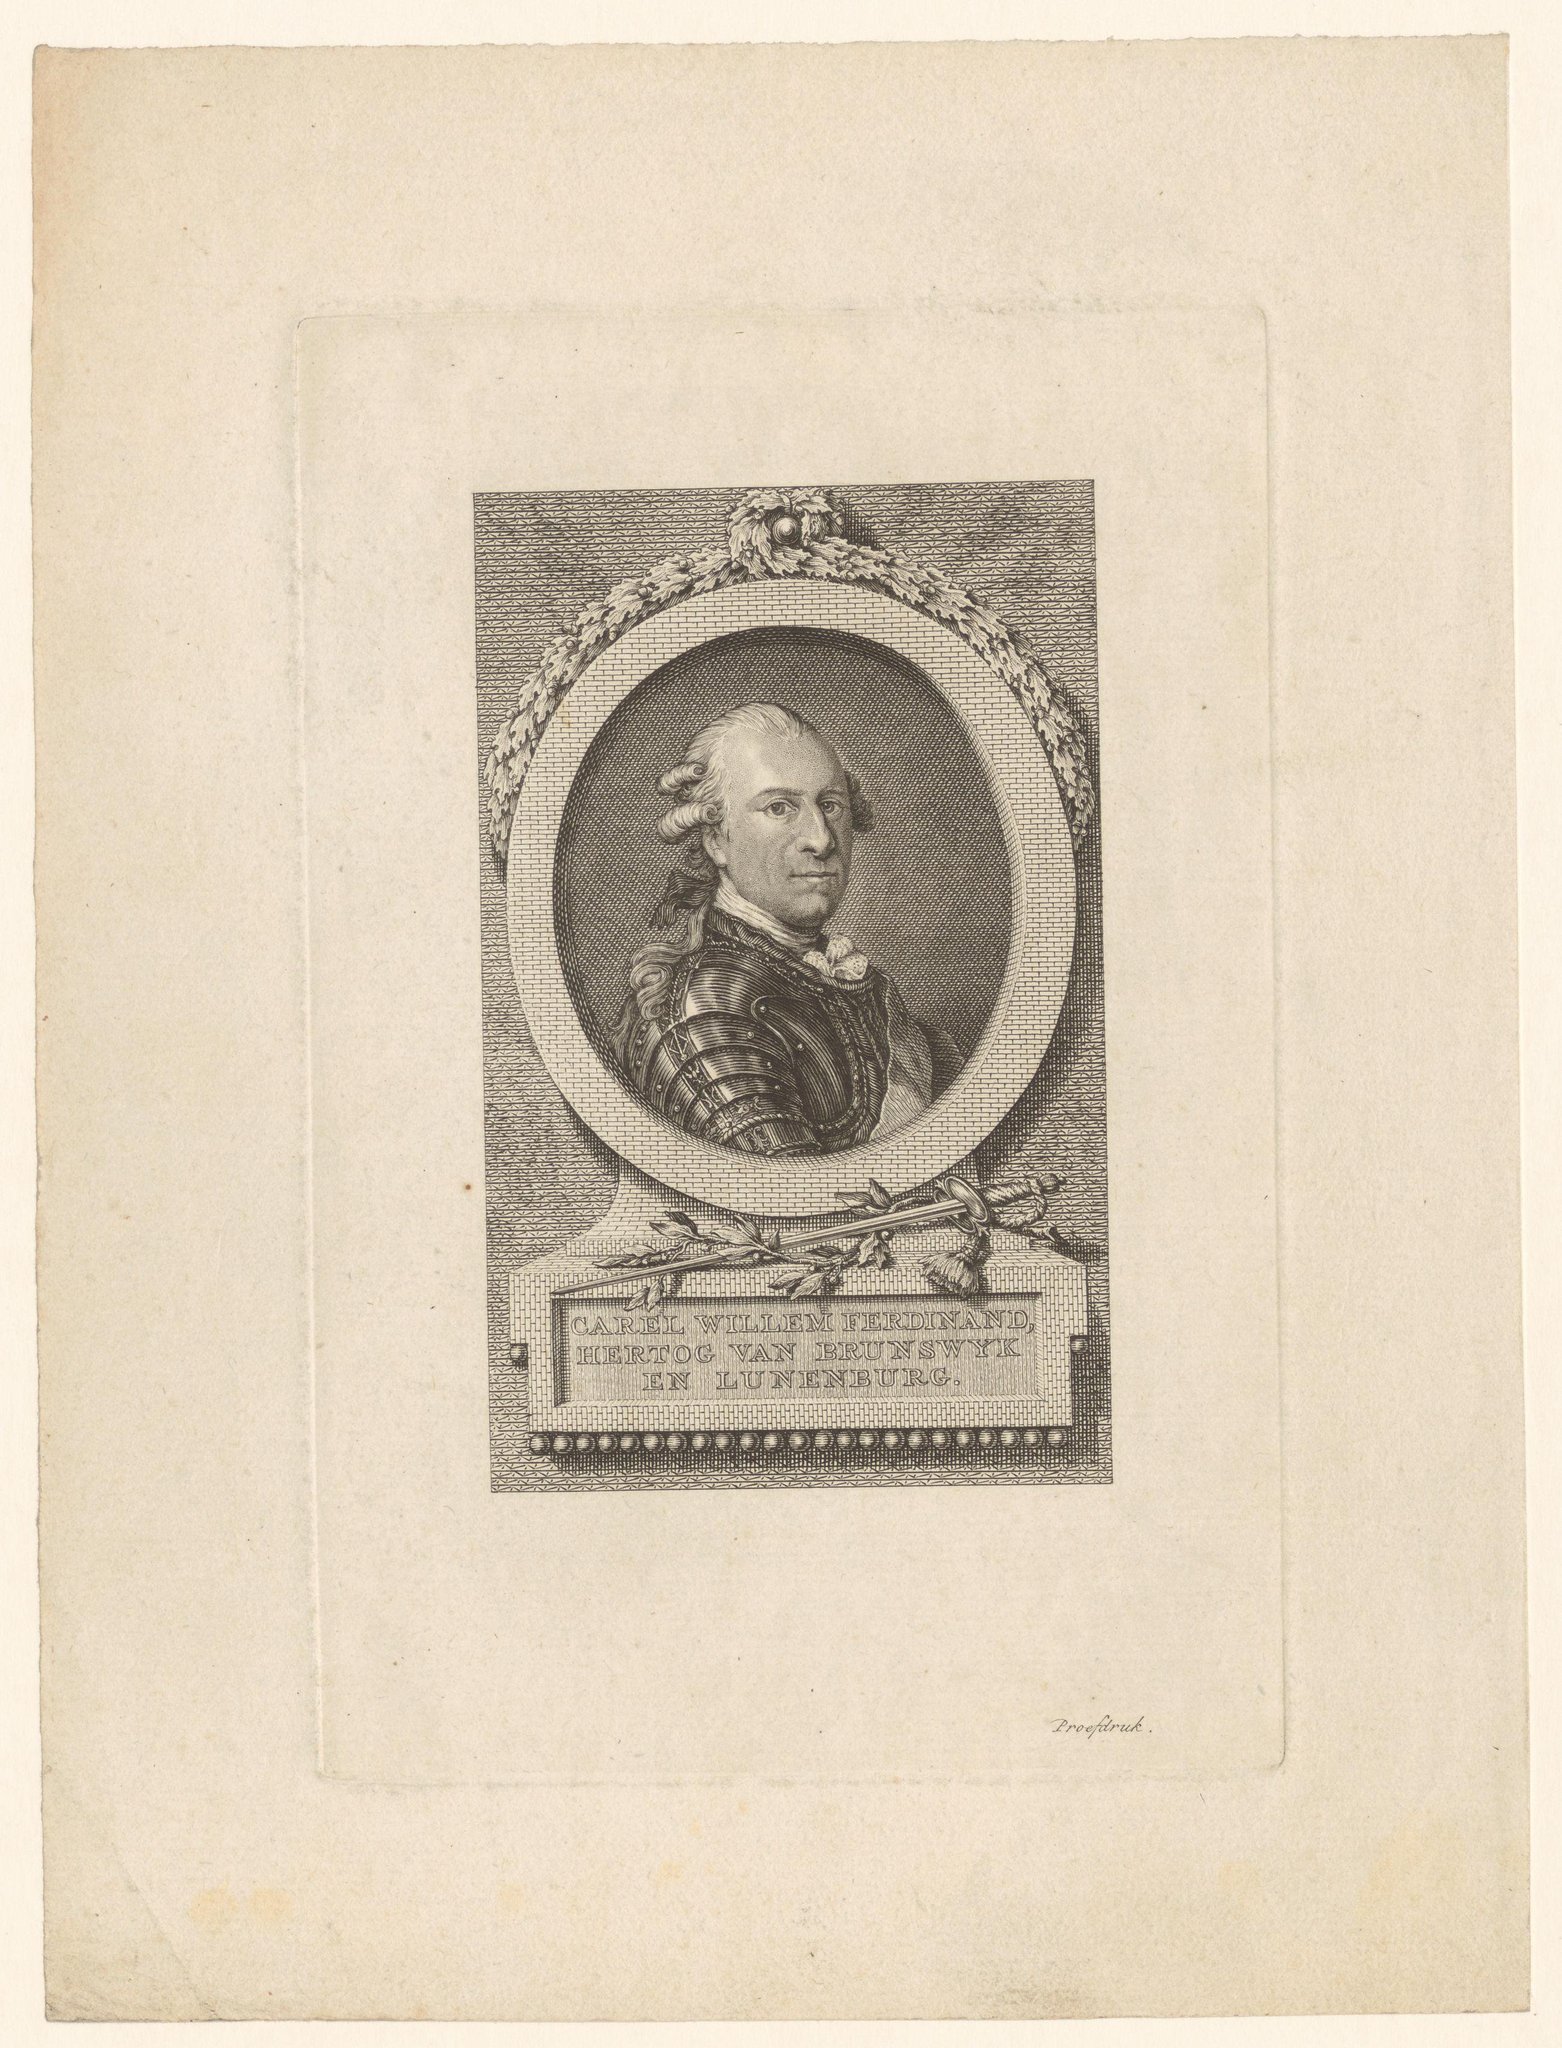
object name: print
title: Portret van Karl Wilhelm Ferdinand von Braunschweig-Wolfenbüttel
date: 1764-1807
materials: paper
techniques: engraving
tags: karl wilhelm ferdinand von braunschweig-wolfenbüttel (hertog), commander-in-chief, general, marshal, historical persons, hacking and thrusting weapons: sword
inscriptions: collector's mark: Lugt 2228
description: Tekst in het Latijn op de sokkel en in de ondermarge.